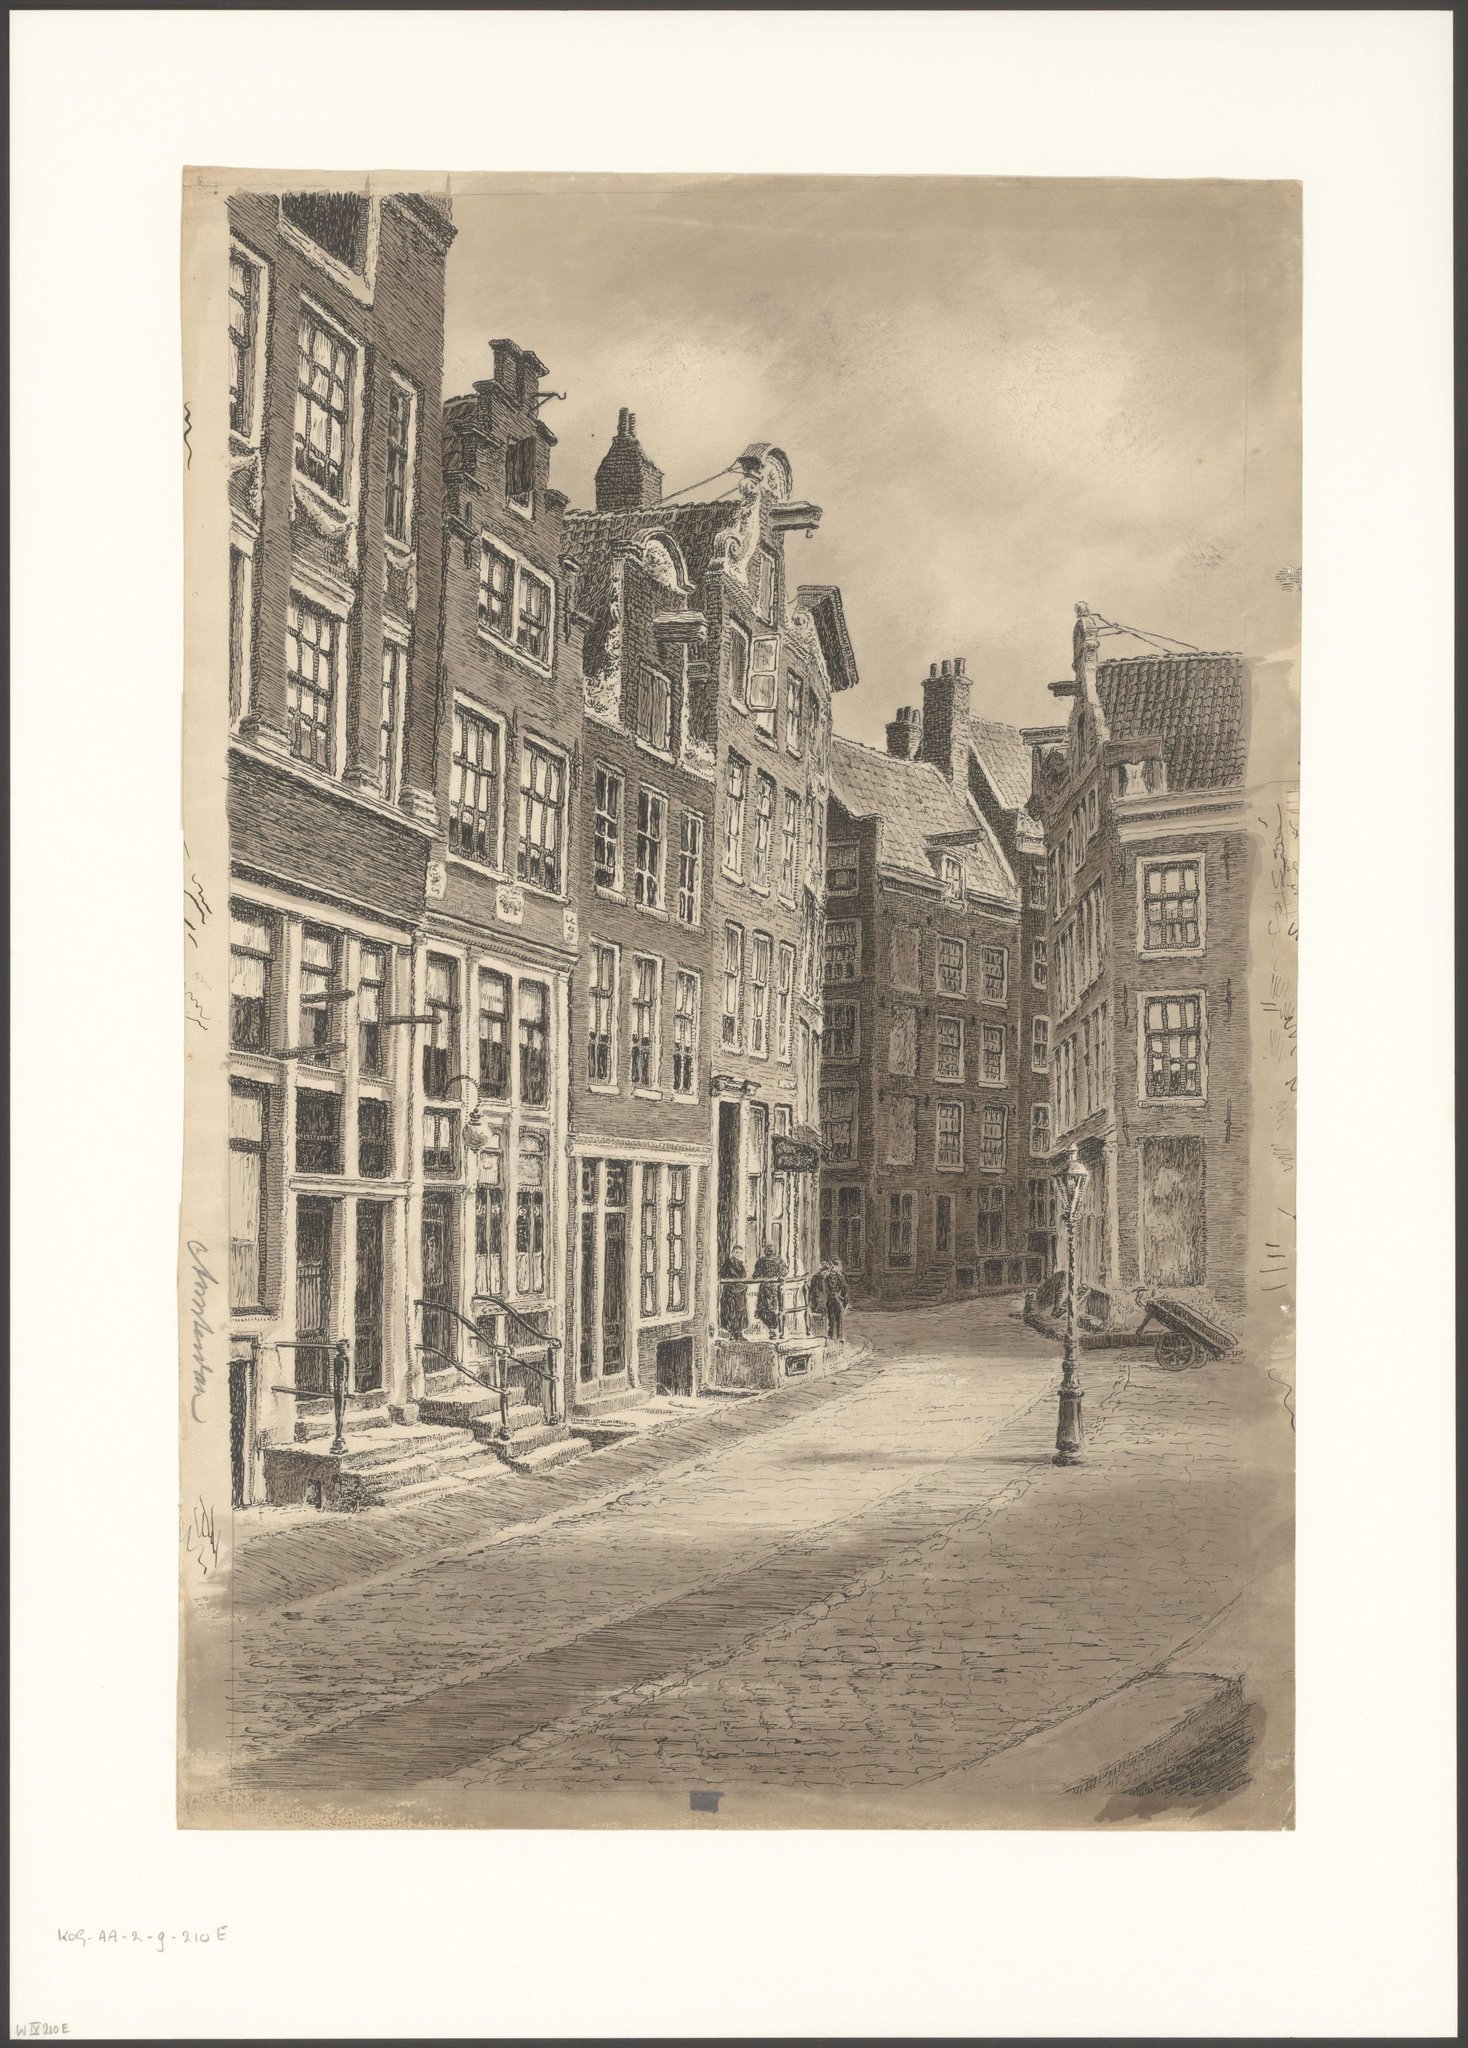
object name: drawing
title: Gezicht op een straat te Amsterdam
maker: Anonymous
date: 1850-1950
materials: ink, paper, pencil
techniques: brush, pen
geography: amsterdam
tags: city-view in general; 'veduta', street, amsterdam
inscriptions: inscription: ‘Amsterdam’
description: Tekening binnen de Atlas Van Eck ingedeeld op wijknummer 9.